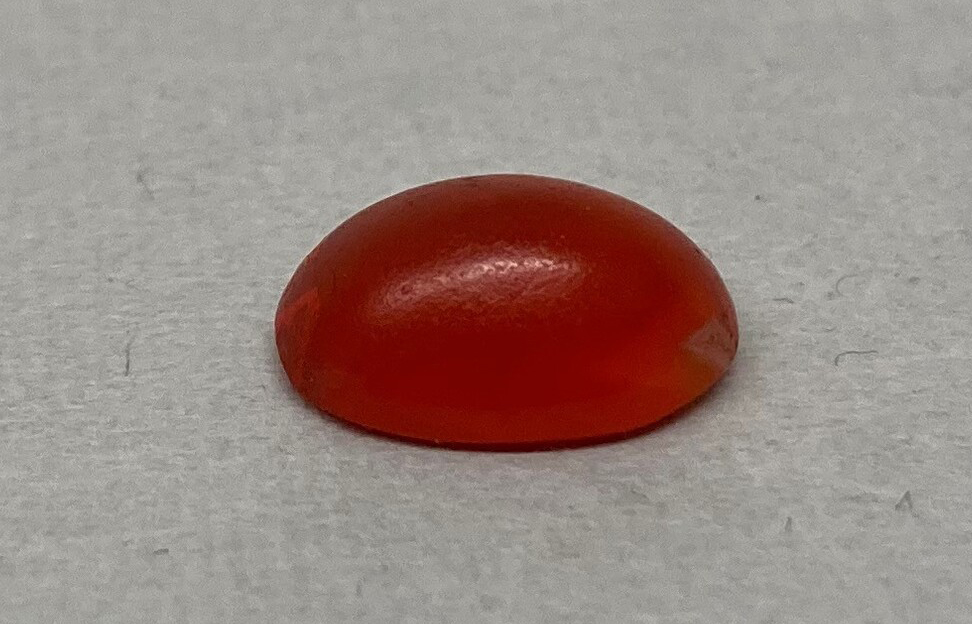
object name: cabochon for a ring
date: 801-1200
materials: gemstone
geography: iran